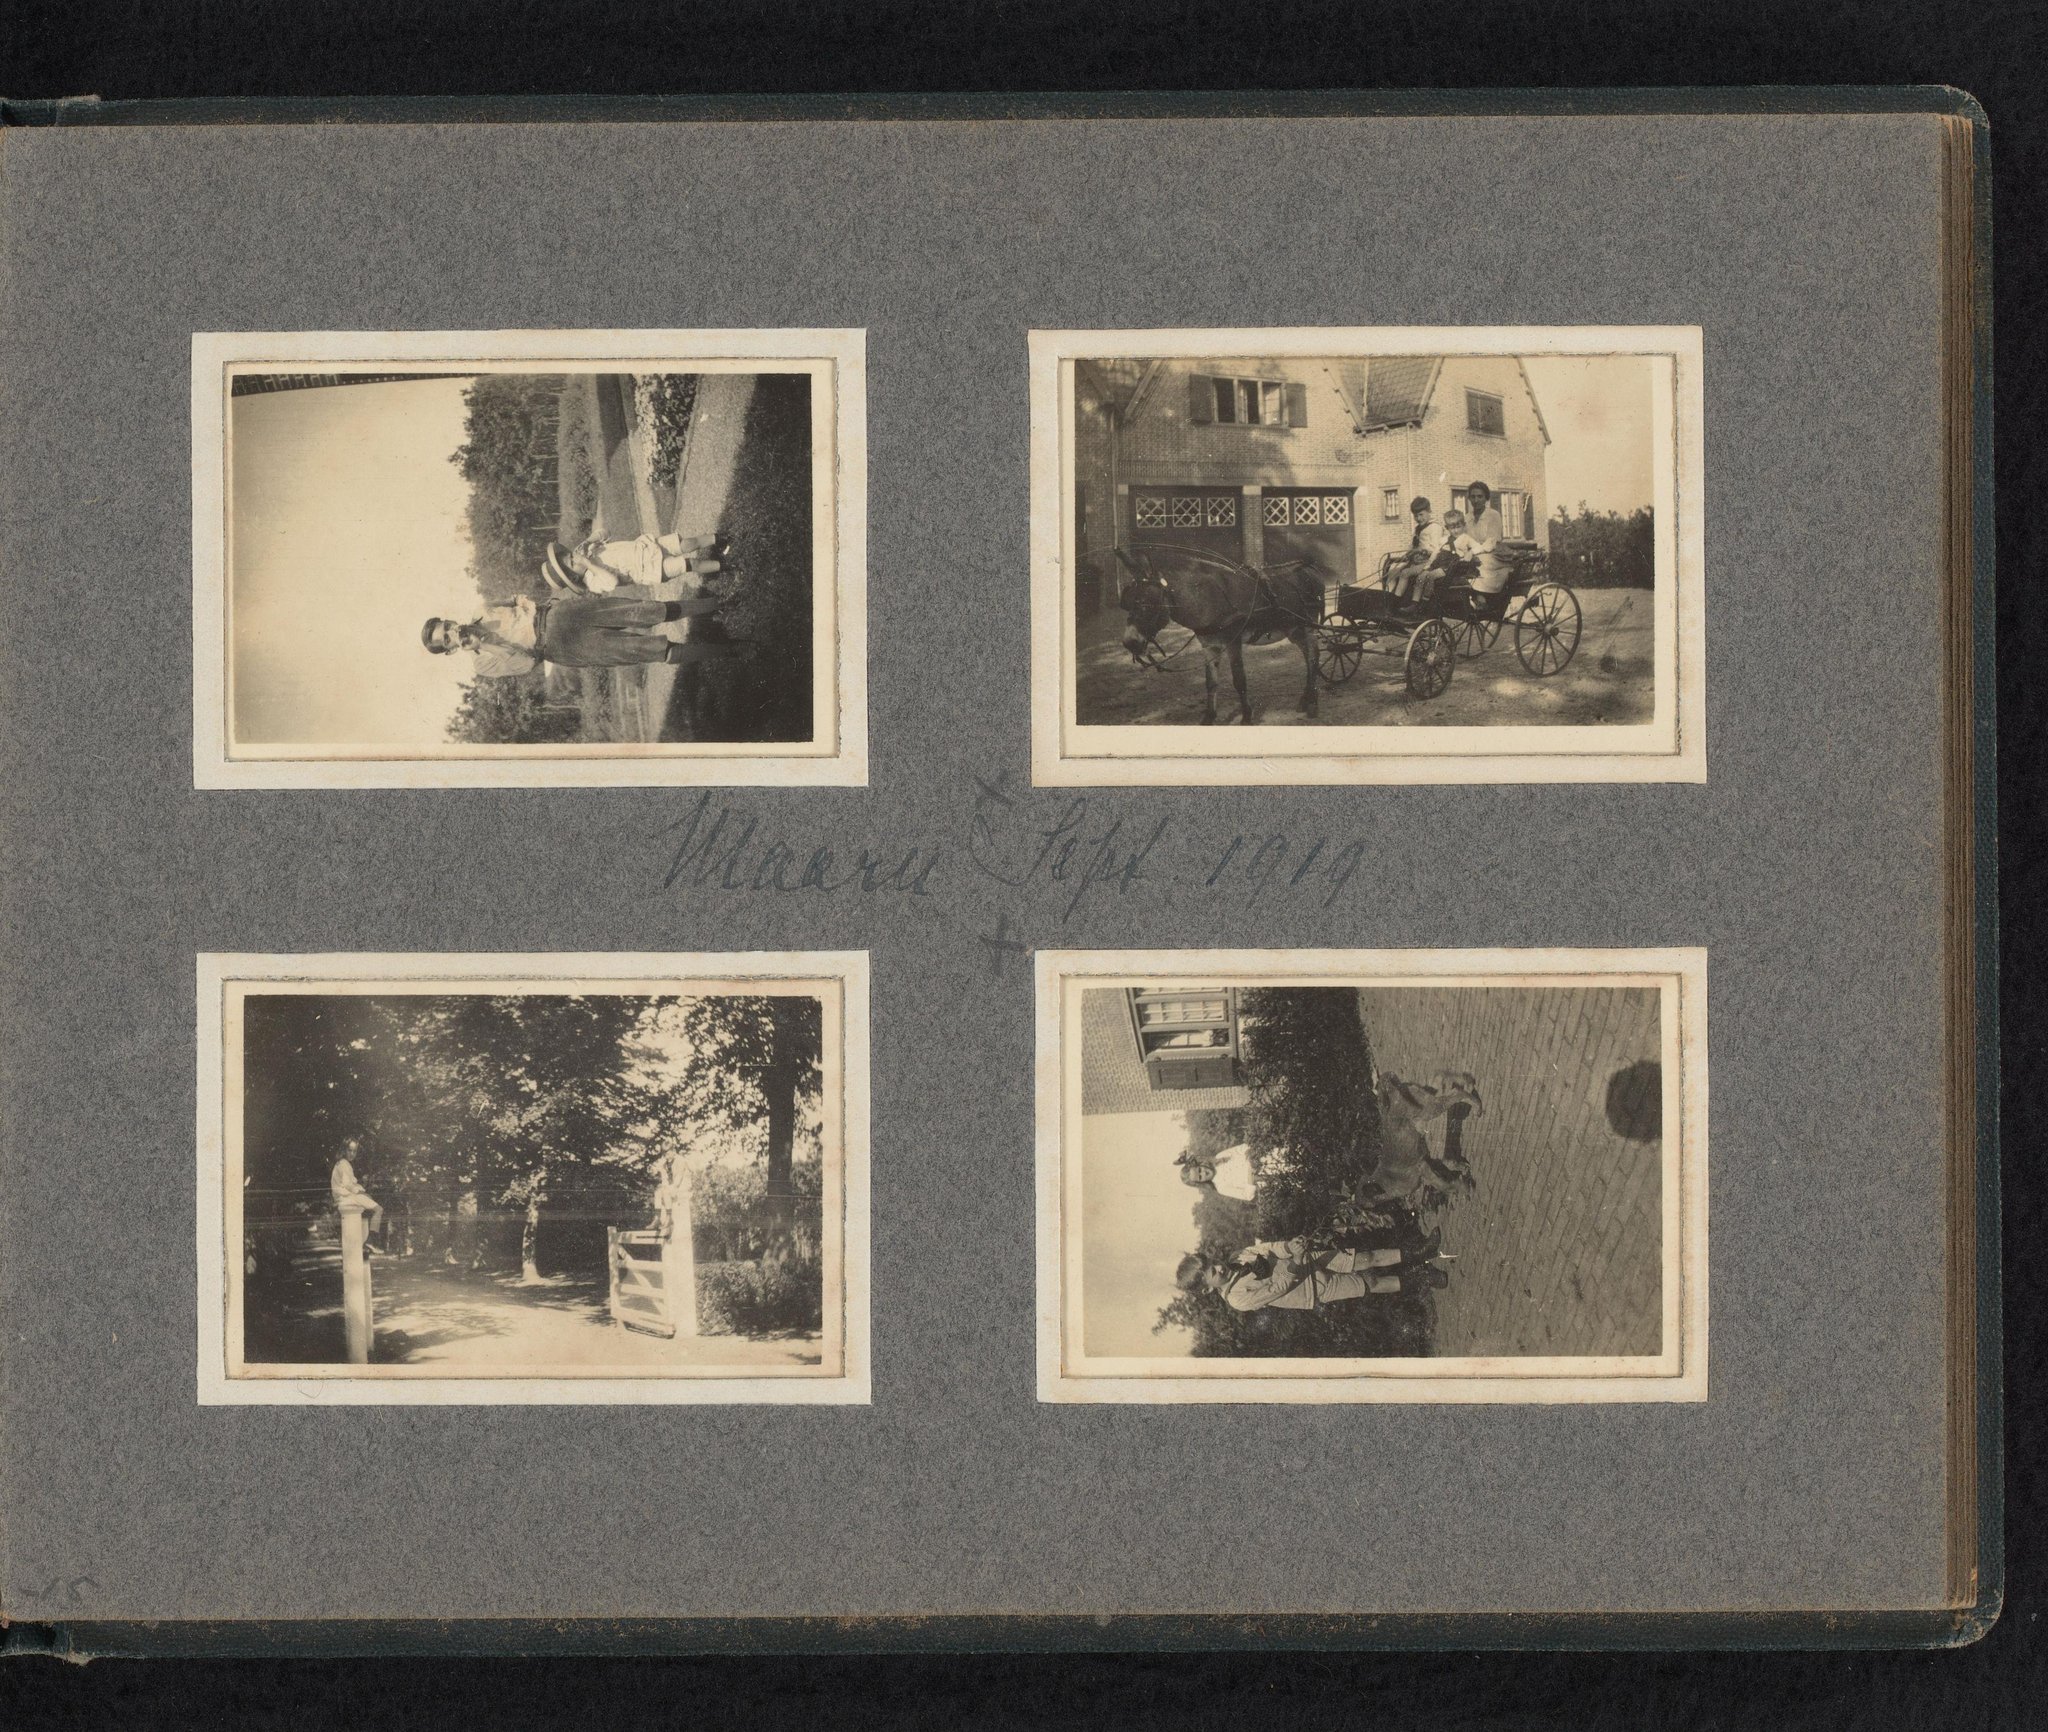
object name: album leaf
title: Familie van den berg in Maarn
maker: hendrik herman van den berg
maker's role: amateurfotograaf, jurist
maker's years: 1875-1944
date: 1909-1919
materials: paper, cardboard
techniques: gelatin silver print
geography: maarn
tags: family life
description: Deze foto's zijn onderdeel van een album.